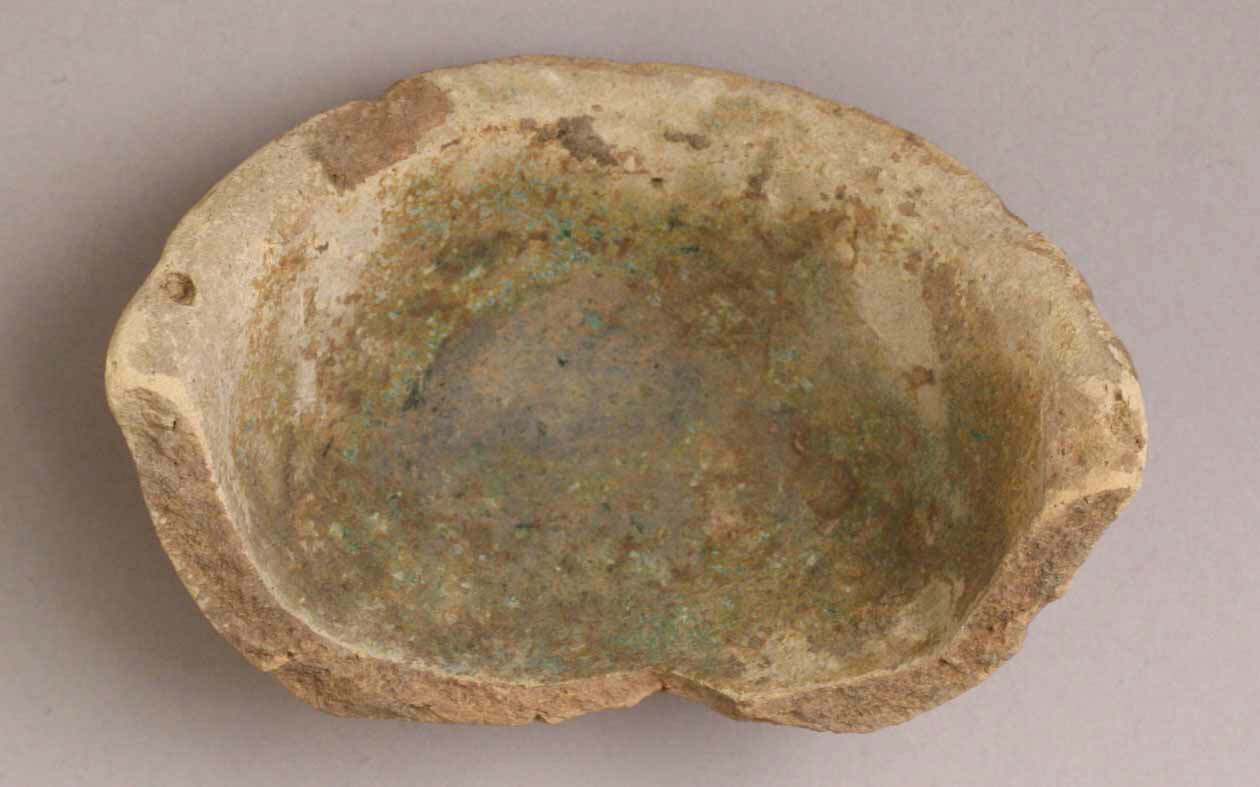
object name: fragment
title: Ceramic Fragment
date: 601-1000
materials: earthenware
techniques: glazing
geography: iraq